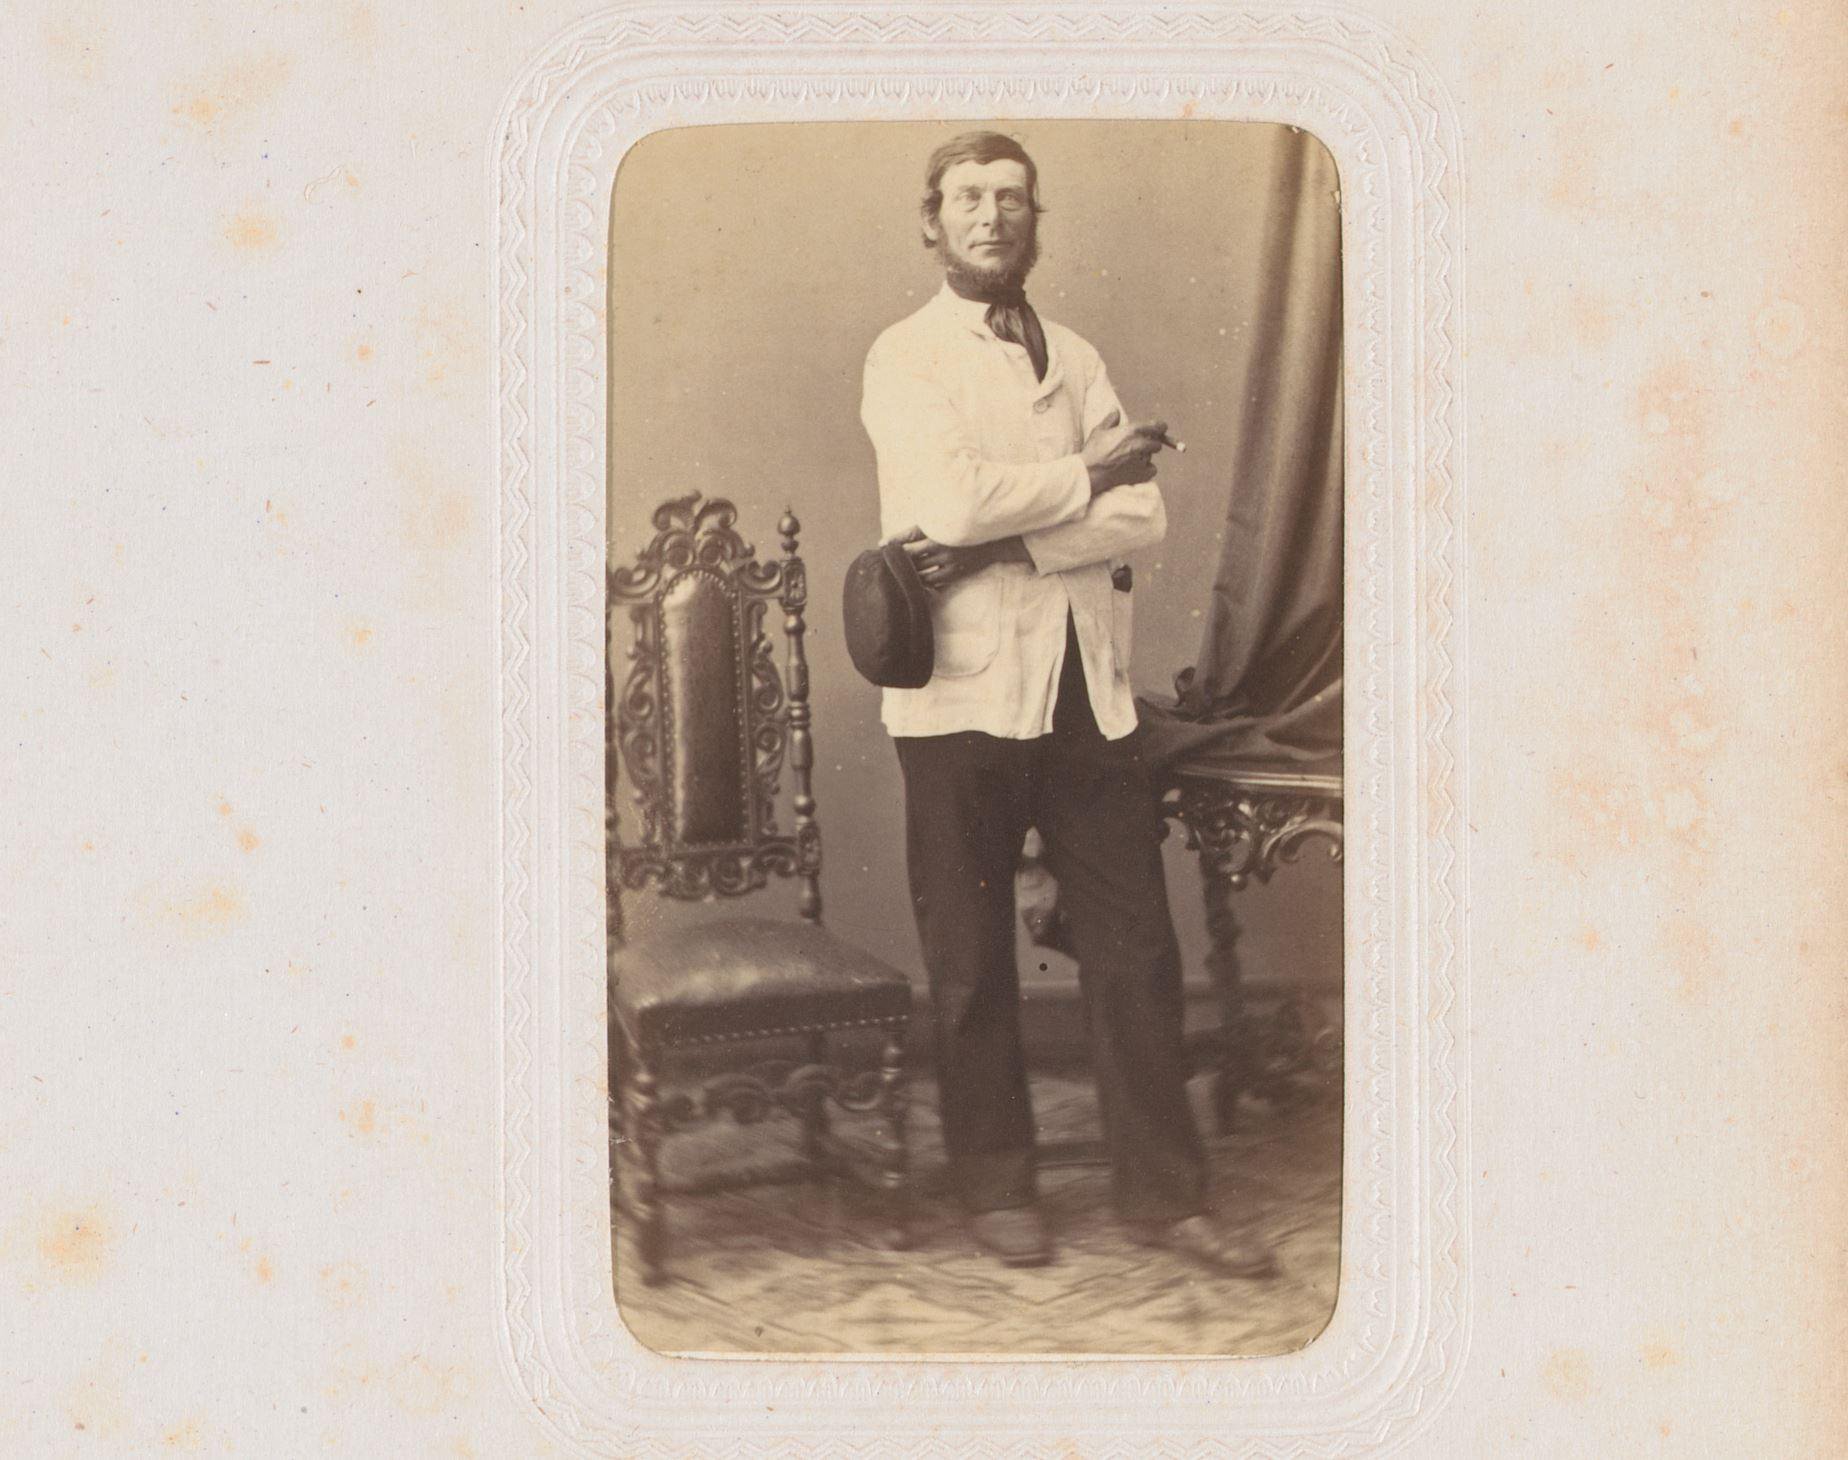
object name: album leaf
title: Portret van een staande man in een witte jas met sigaar en pet in de handen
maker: kornelis willem schorteldoek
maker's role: boekbinder, fotograaf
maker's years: 1800-1885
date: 1855-1885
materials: cardboard, photographic support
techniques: albumen print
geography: gorinchem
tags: cigar, coat, historical persons, head-gear: cap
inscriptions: inscription: ‘SCHORTELDOEK/ PHOTOGRAAF/ GORINCHEM/ Groote Markt’